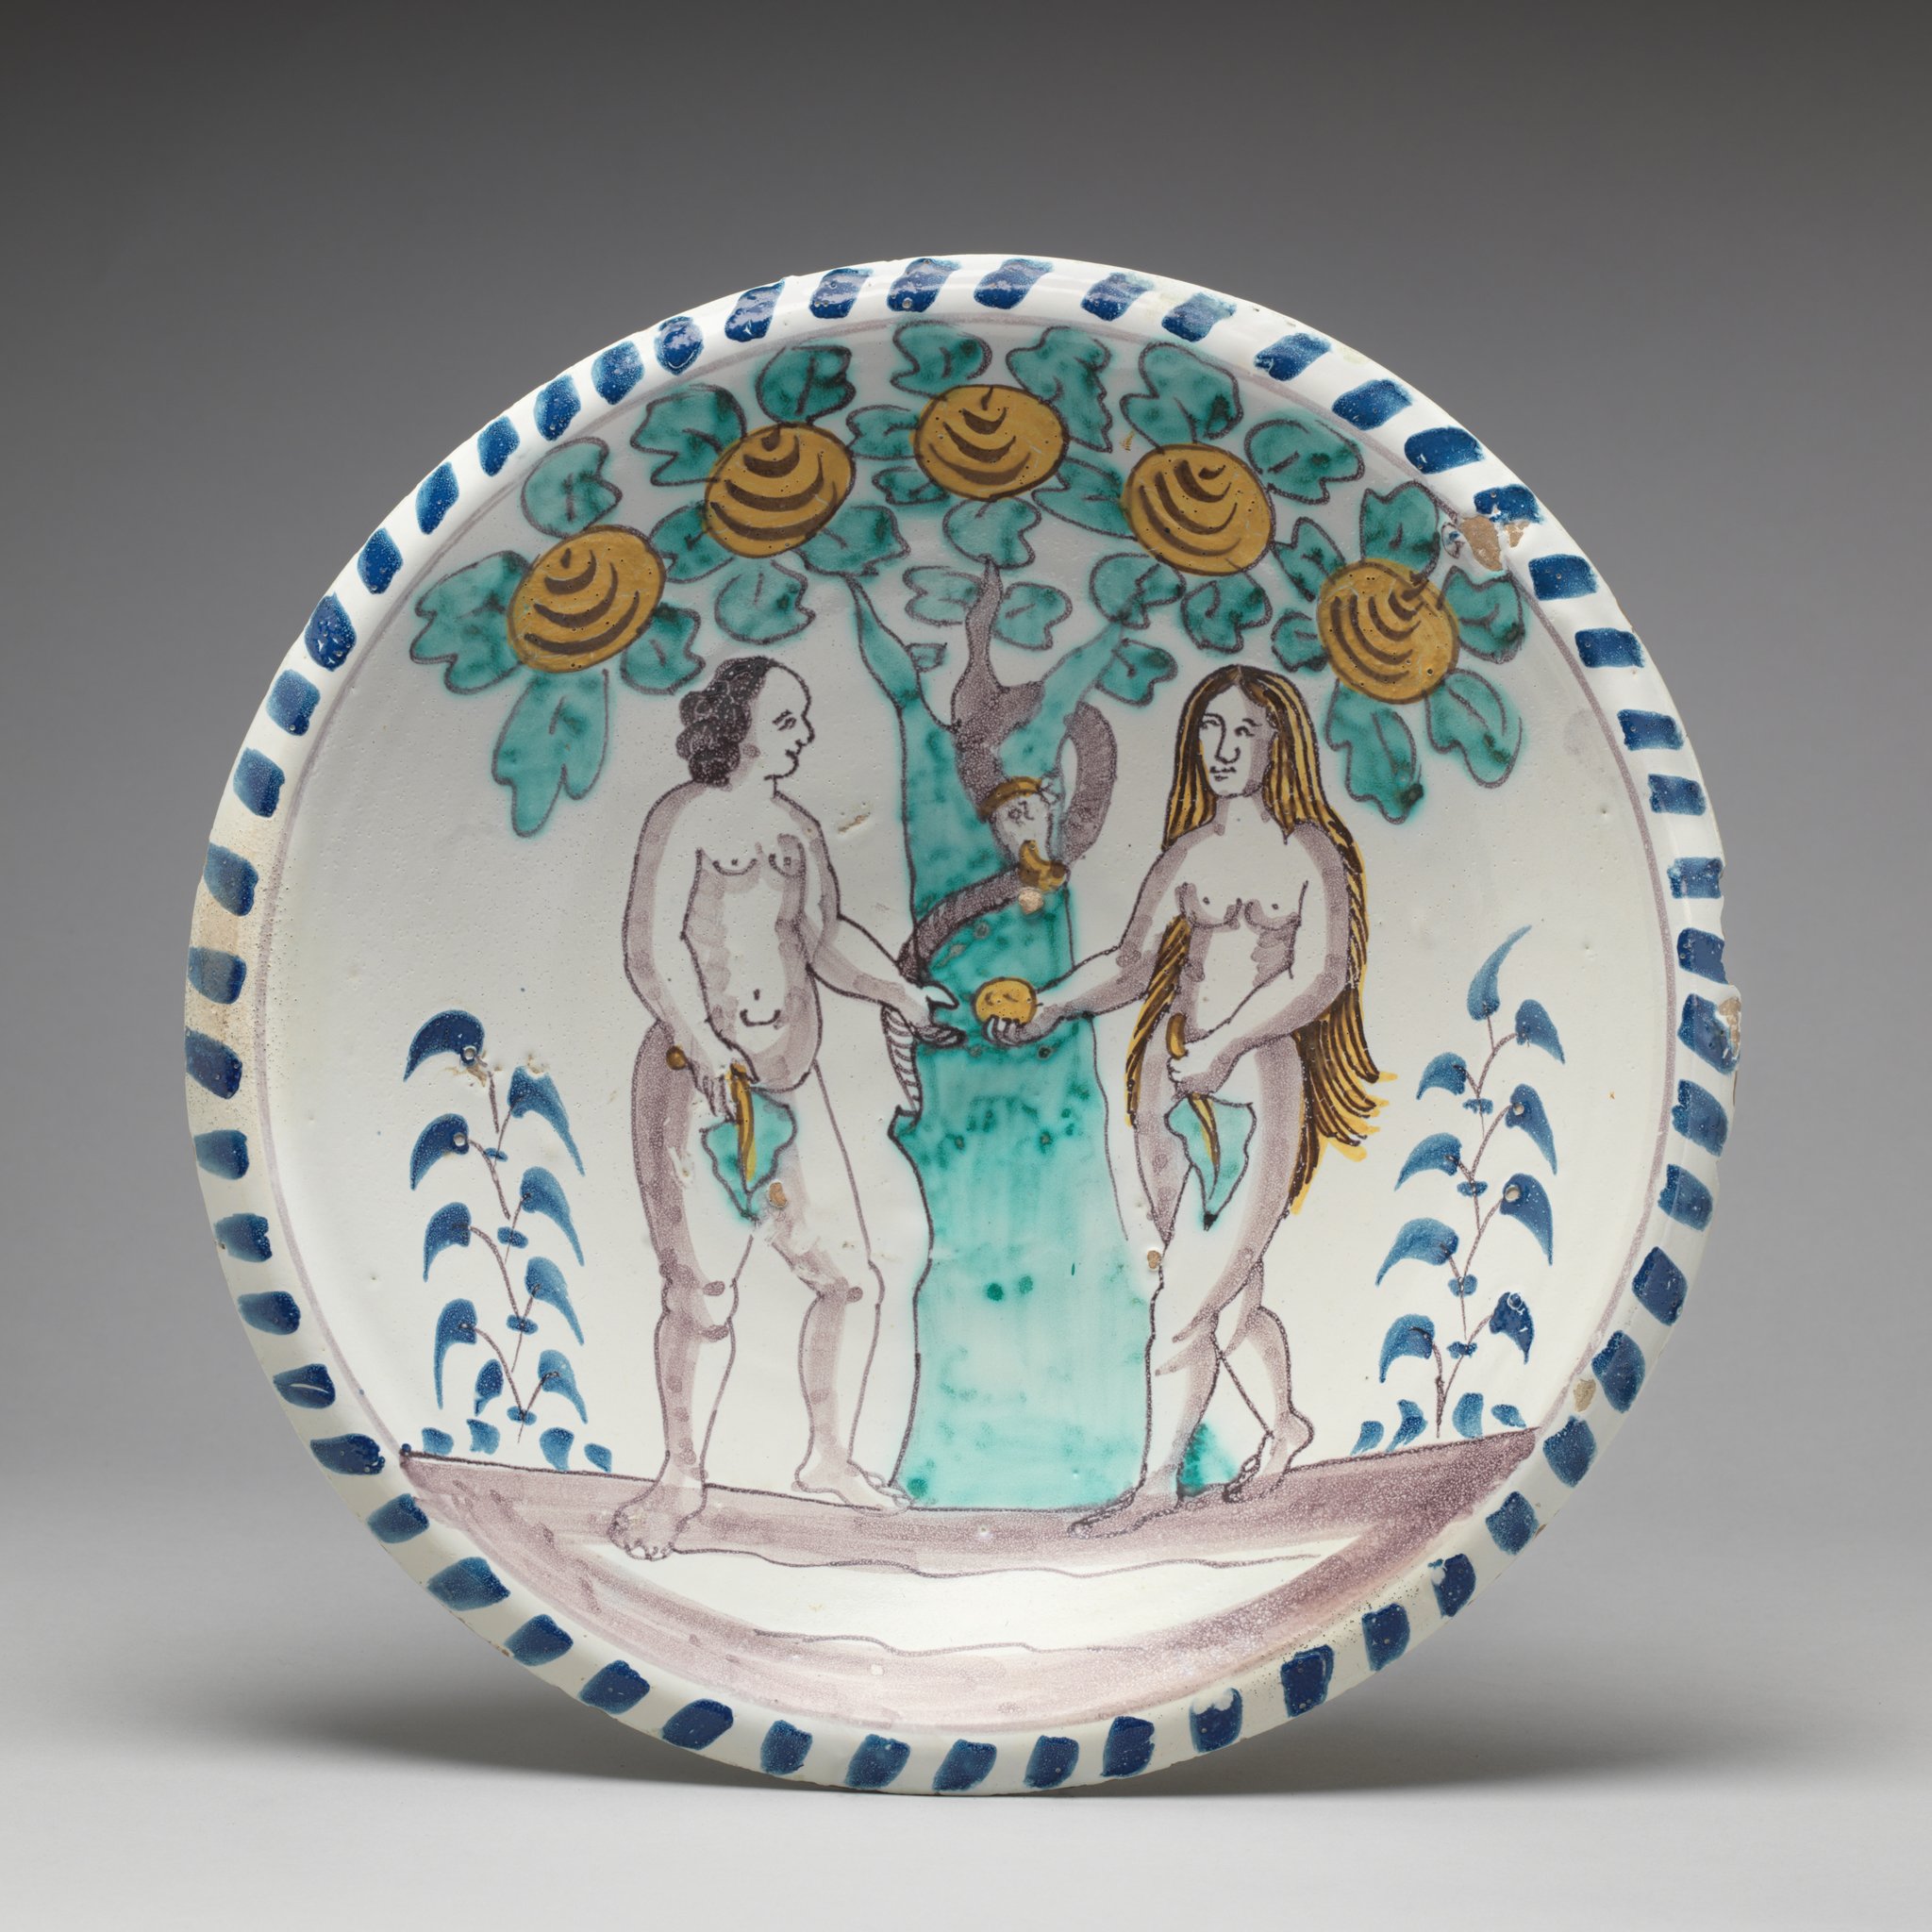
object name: dish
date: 1667-1733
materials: earthenware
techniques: glazing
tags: snakes,trees,adam,eve